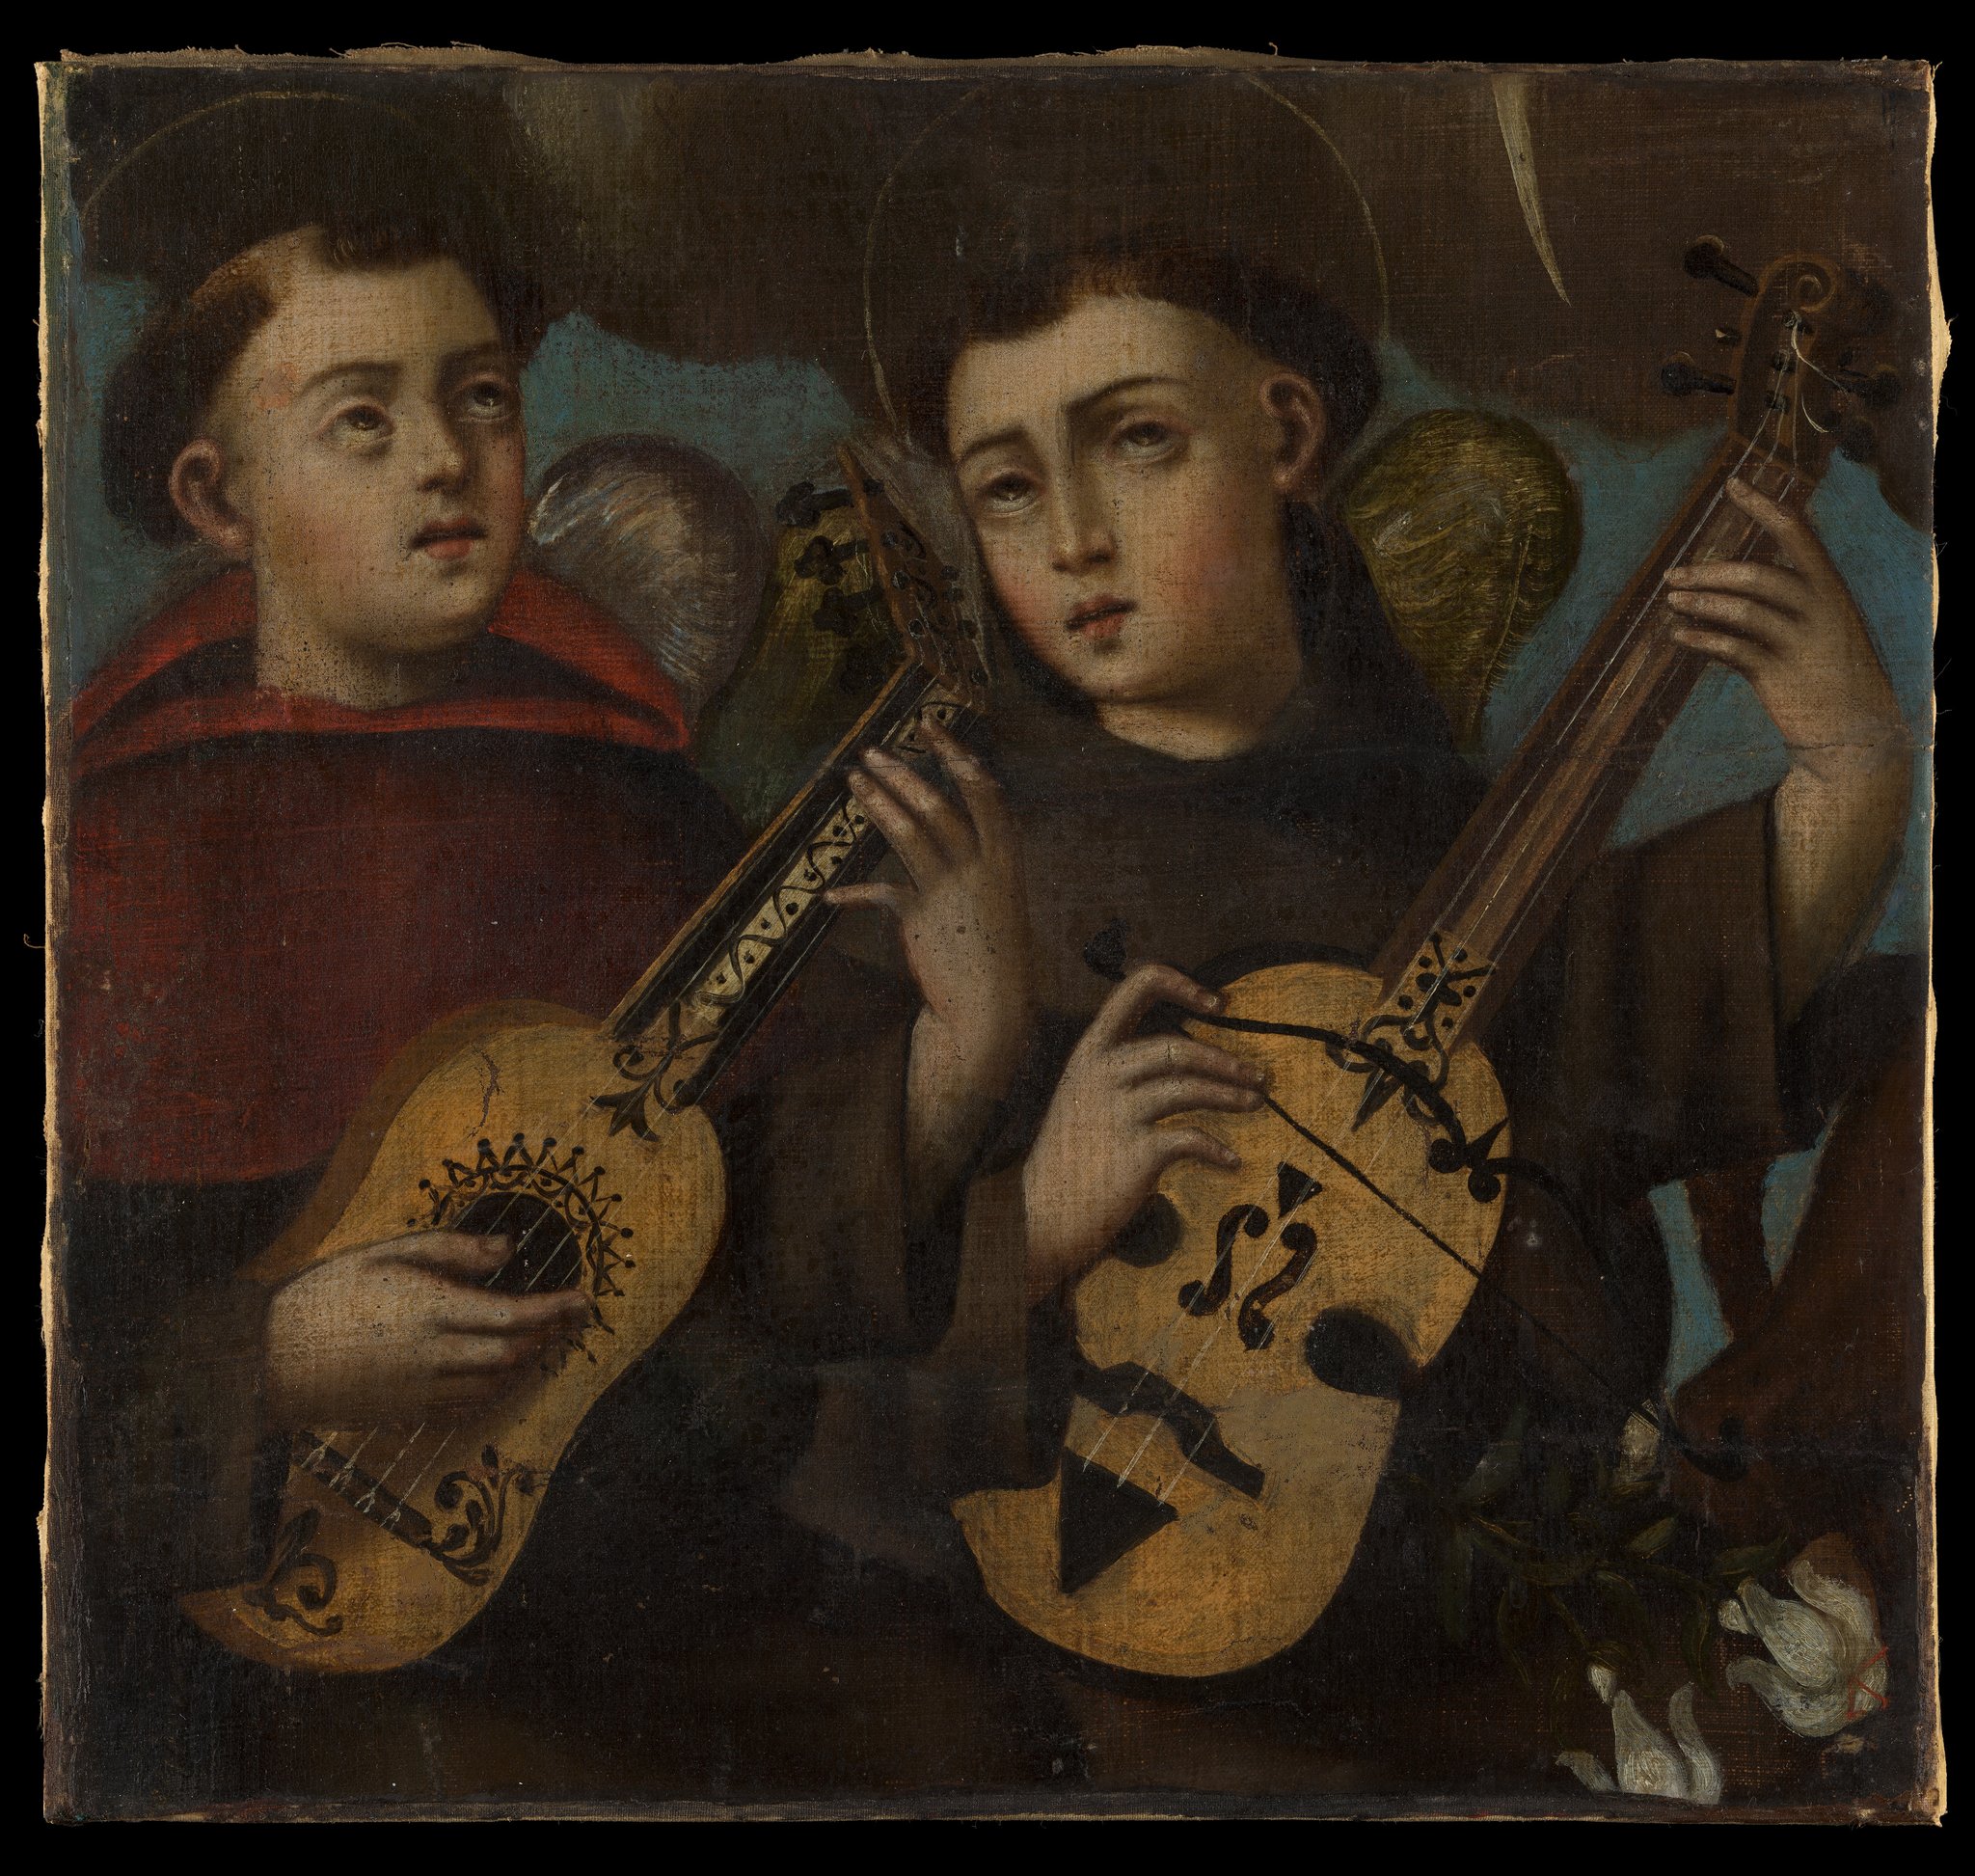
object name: painting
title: Saint Bonaventure and Saint Anthony of Padua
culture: peruvian, cuzco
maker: basilio santa cruz pumacallao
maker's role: artist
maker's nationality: peruvian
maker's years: 1635-1710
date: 1670-1690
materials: canvas, oil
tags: musical instruments,men,saints